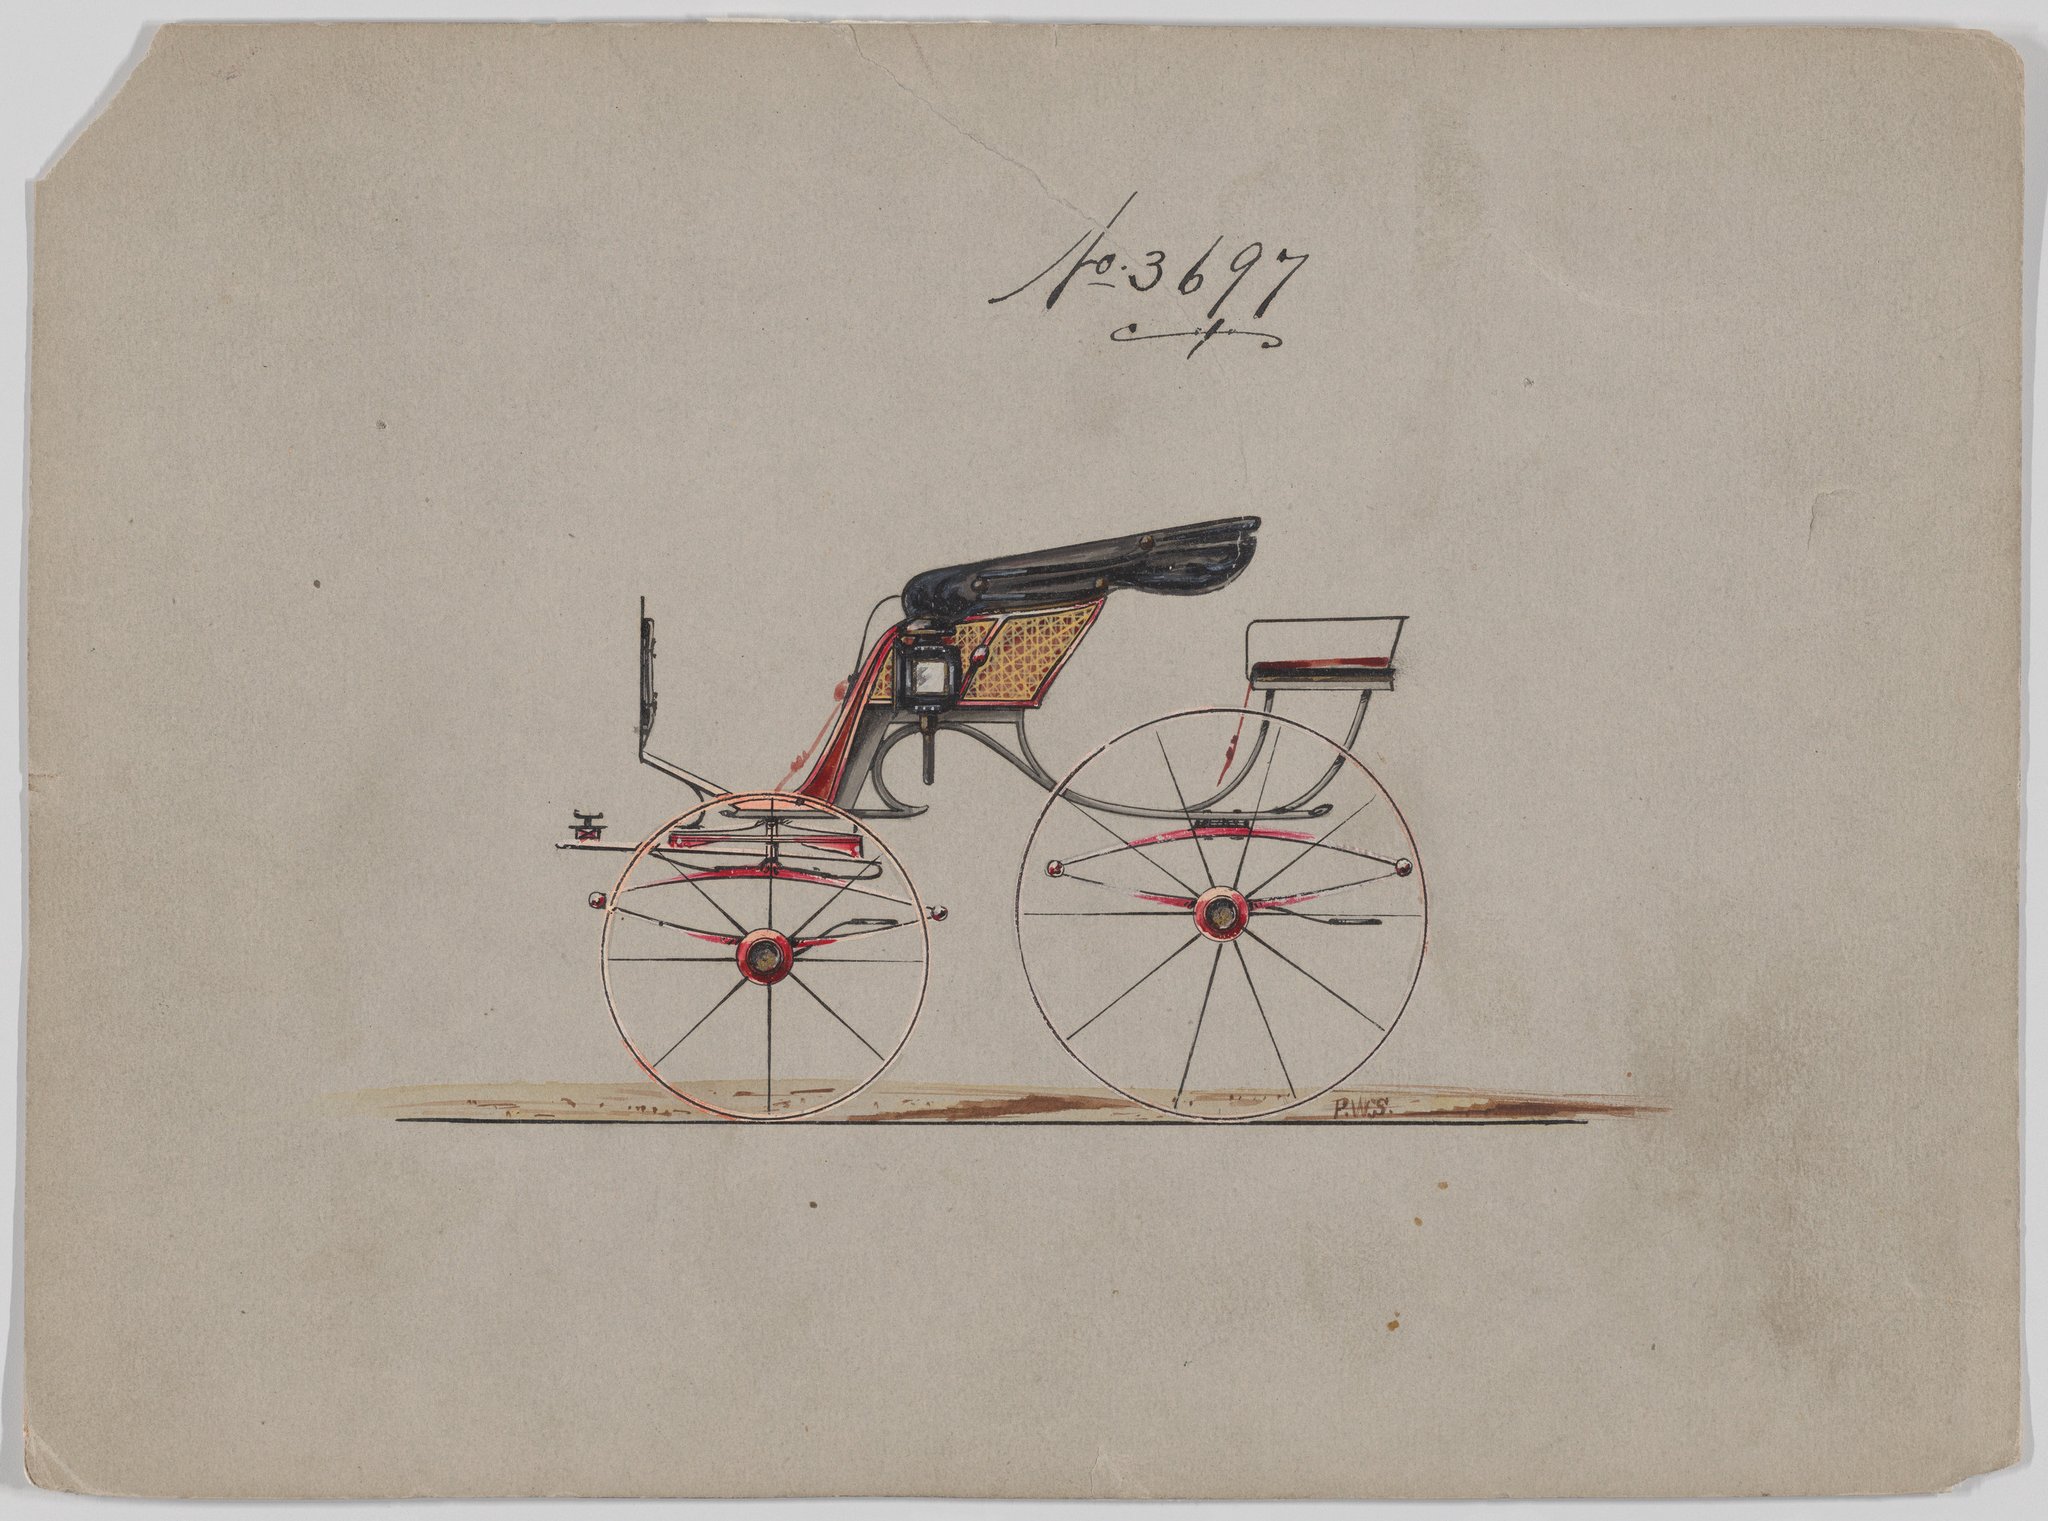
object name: drawing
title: Design for Pony Phaeton, no. 3697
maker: brewster & co.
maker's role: manufacturer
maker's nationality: american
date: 1881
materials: gouache, gum arabic, ink, watercolor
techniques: pen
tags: carriages